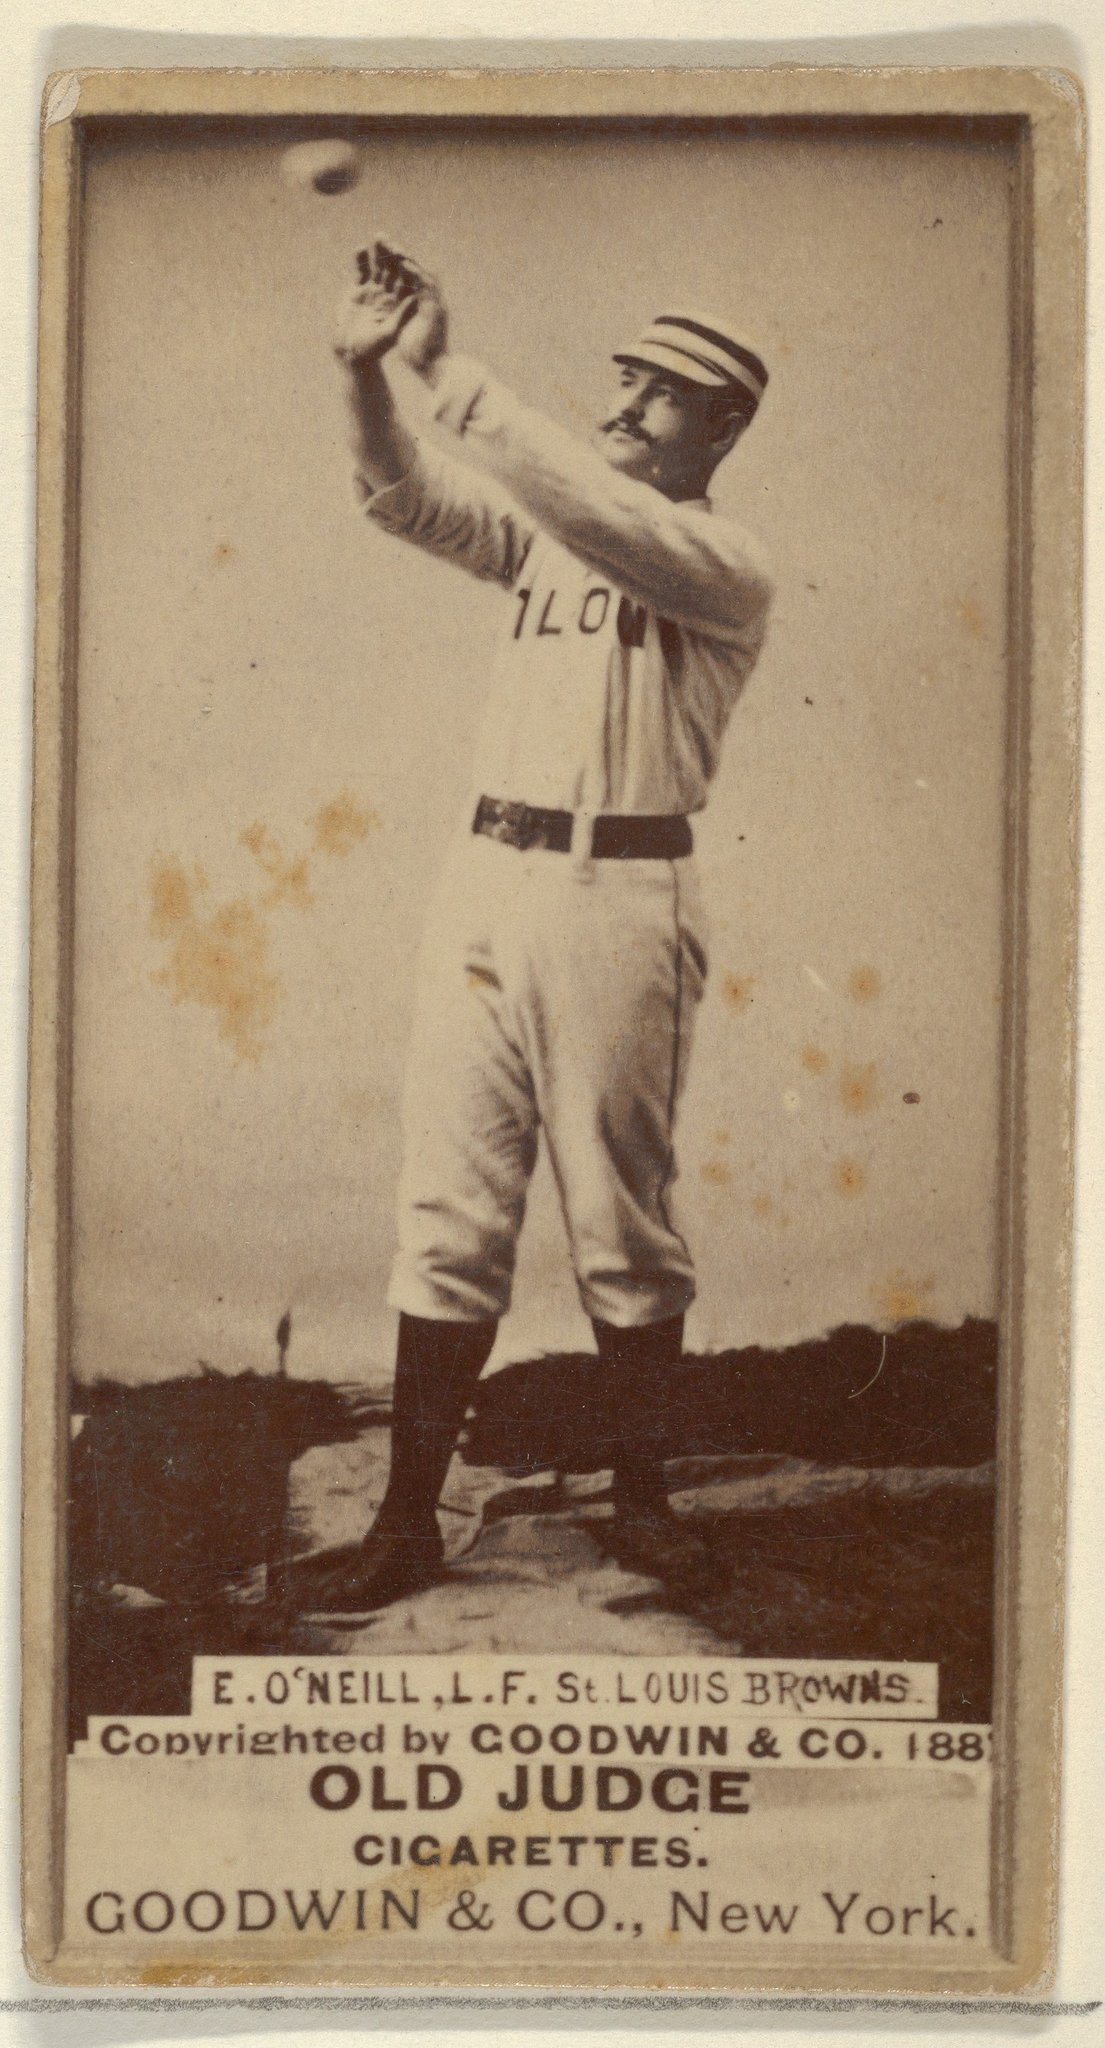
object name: baseball card, photograph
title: James Edward "Tip" O'Neill, Left Field, St. Louis Browns, from the Old Judge series (N172) for Old Judge Cigarettes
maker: goodwin & company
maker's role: publisher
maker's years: 1850-1950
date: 1887-1890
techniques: albumen silver print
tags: men,portraits,baseball,athletes